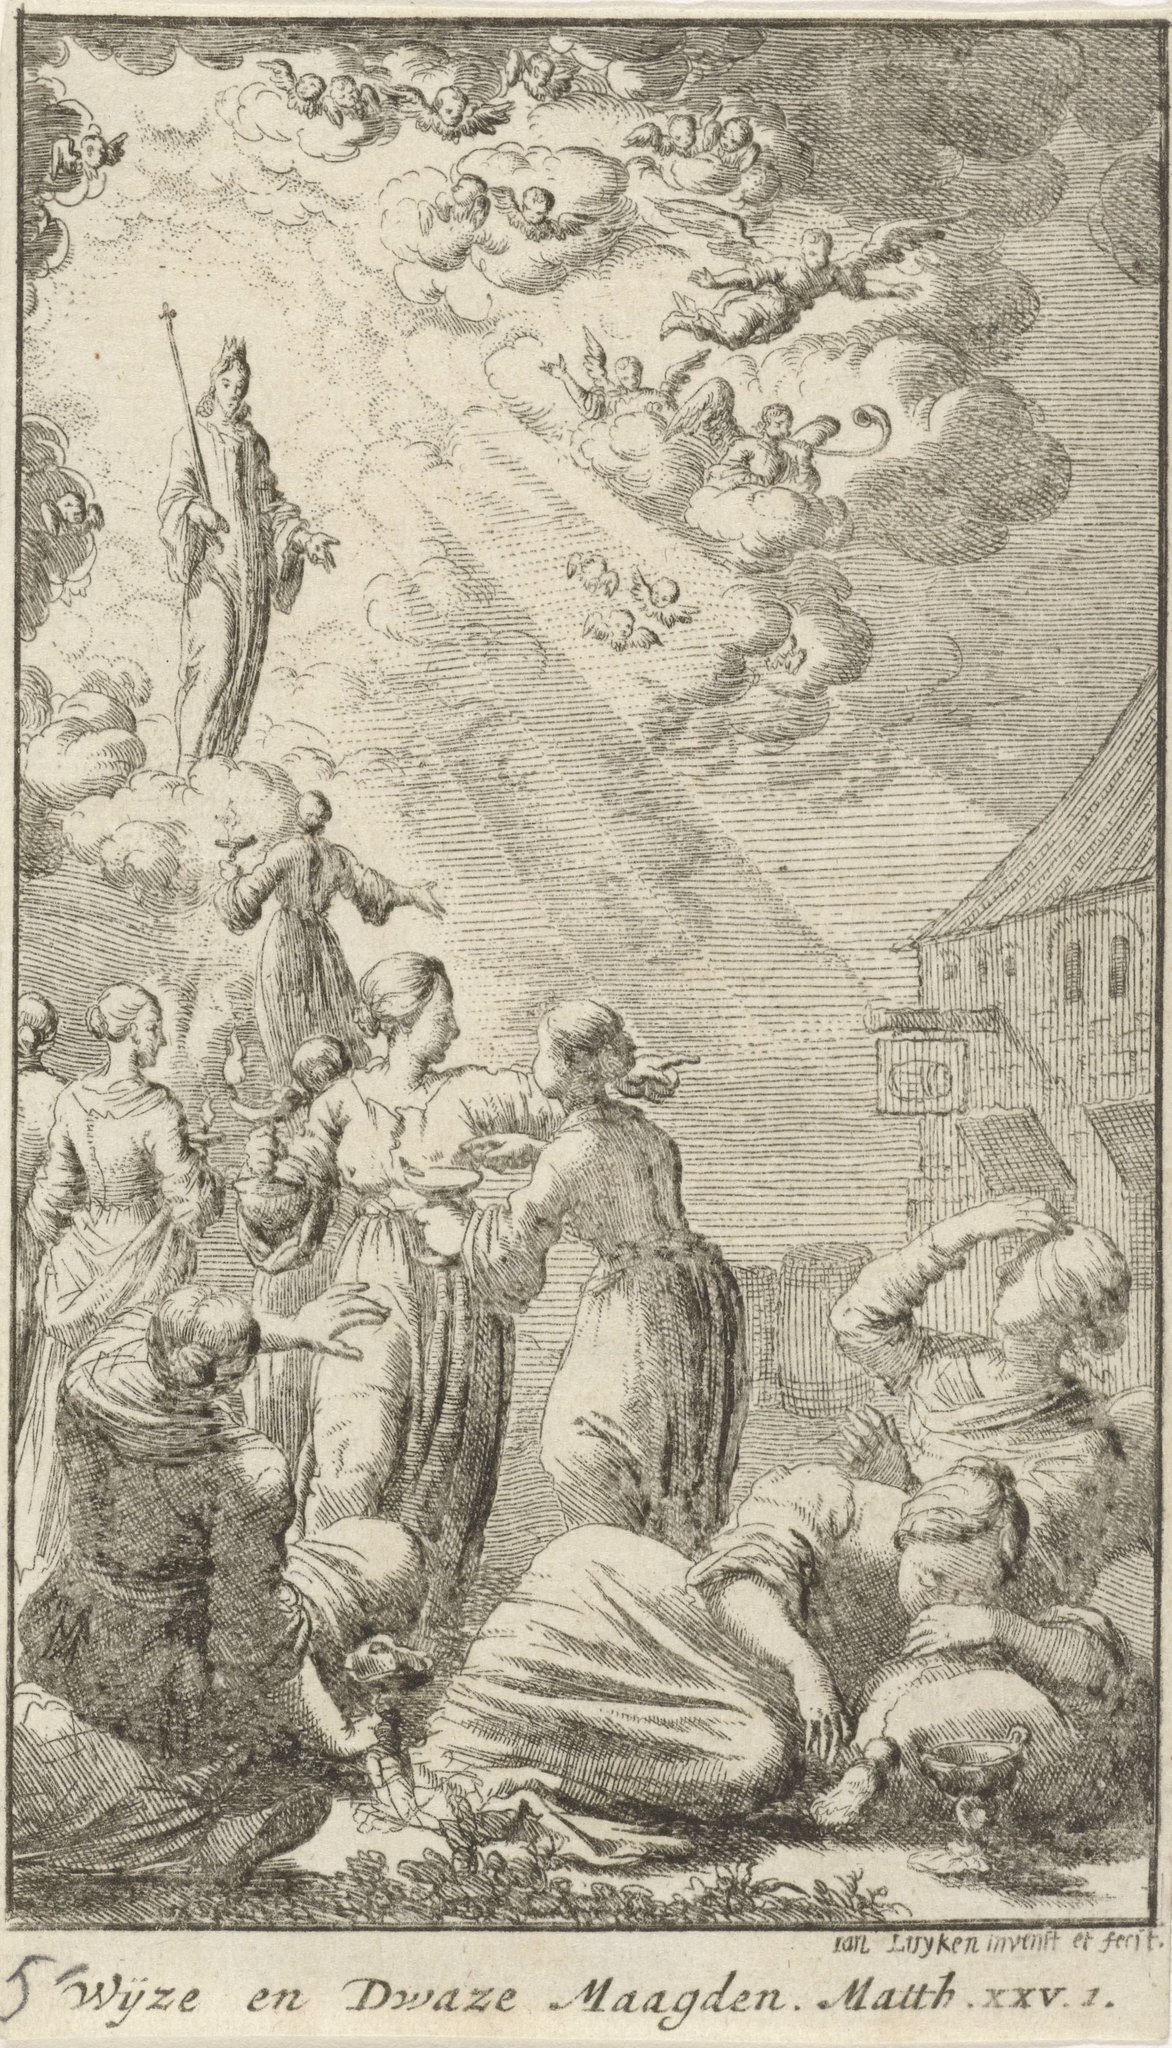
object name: print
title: Vierentwintig scènes uit het Nieuwe Testament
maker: jan luyken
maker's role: draughtsman, print maker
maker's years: 1649-1712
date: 1681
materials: paper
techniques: etching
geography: amsterdam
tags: the wise and the foolish virgins ~ parable of christ (matthew 25:1-13)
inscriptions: number: ‘5’, collector's mark: Lugt 240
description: Twintig prenten van deze serie (waaronder de hier besproken prent) verschenen mogelijk voor het eerst in: Het Nieuwe Testament ofte alle Boecken des Nieuwen Verbondts onses Heeren Iesu Christi. Amsterdam: Hieronymus Sweerts, Jan ten Hoorn, Jan Bouman en Daniel van den Dalen, 1681. De complete vierentwintigdelige serie prenten is opgenomen in: Het Nieuwe Testament ofte alle Boecken des Nieuwen Verbondts onses Heeren Iesu Christi. Dordrecht: Pieter en Jacob Keur, 172X (niet voor 1727). De prenten werden, hetzij alle tezamen, hetzij gedeeltelijk, veel gebruikt tot versiering van Nieuwe Testamenten en verschenen tevens in kopie.